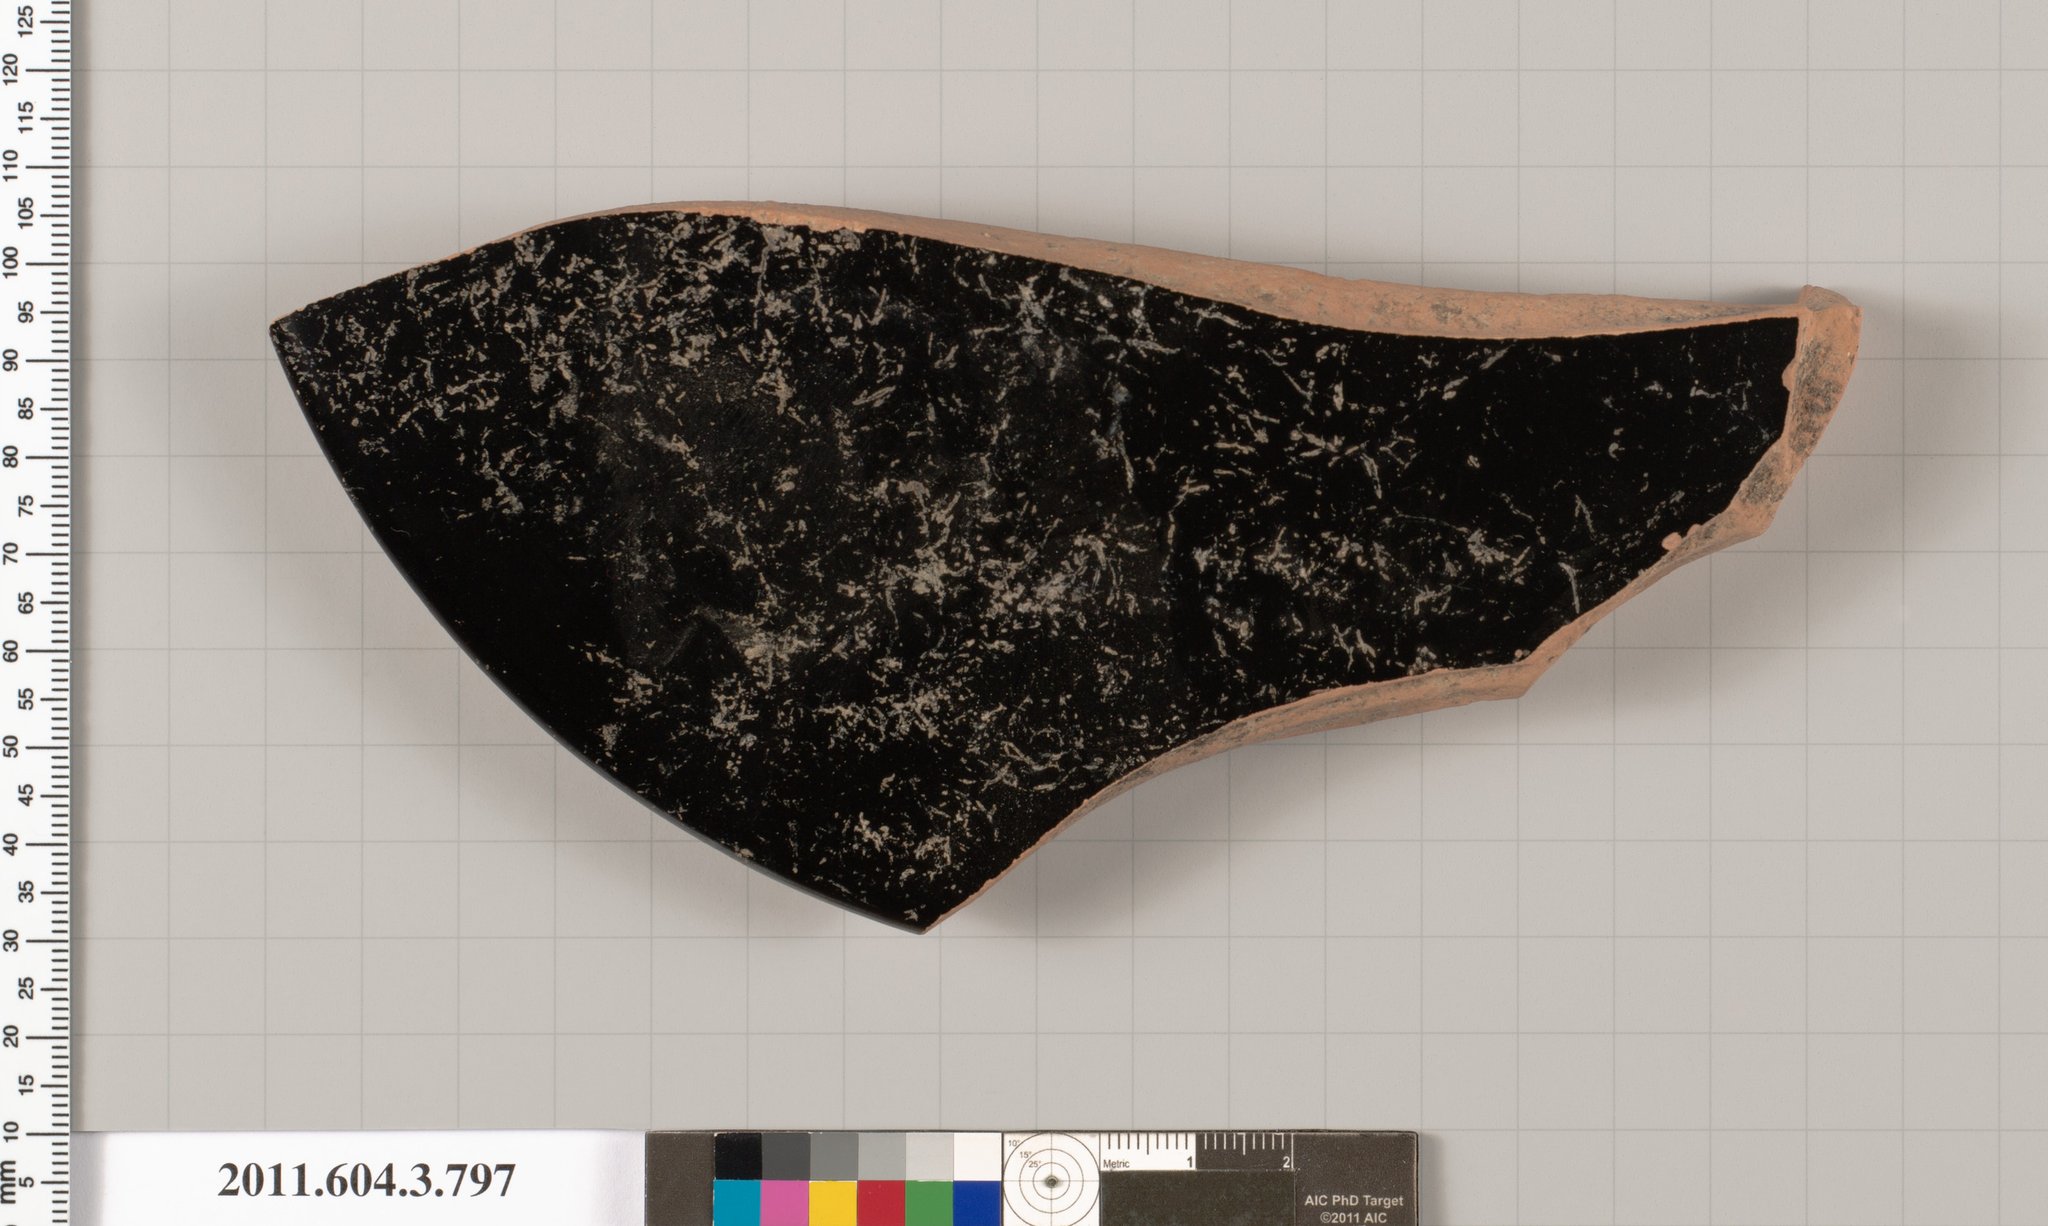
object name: lid fragment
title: Terracotta fragment of a lid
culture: greek, attic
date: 600-501 BCE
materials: terracotta